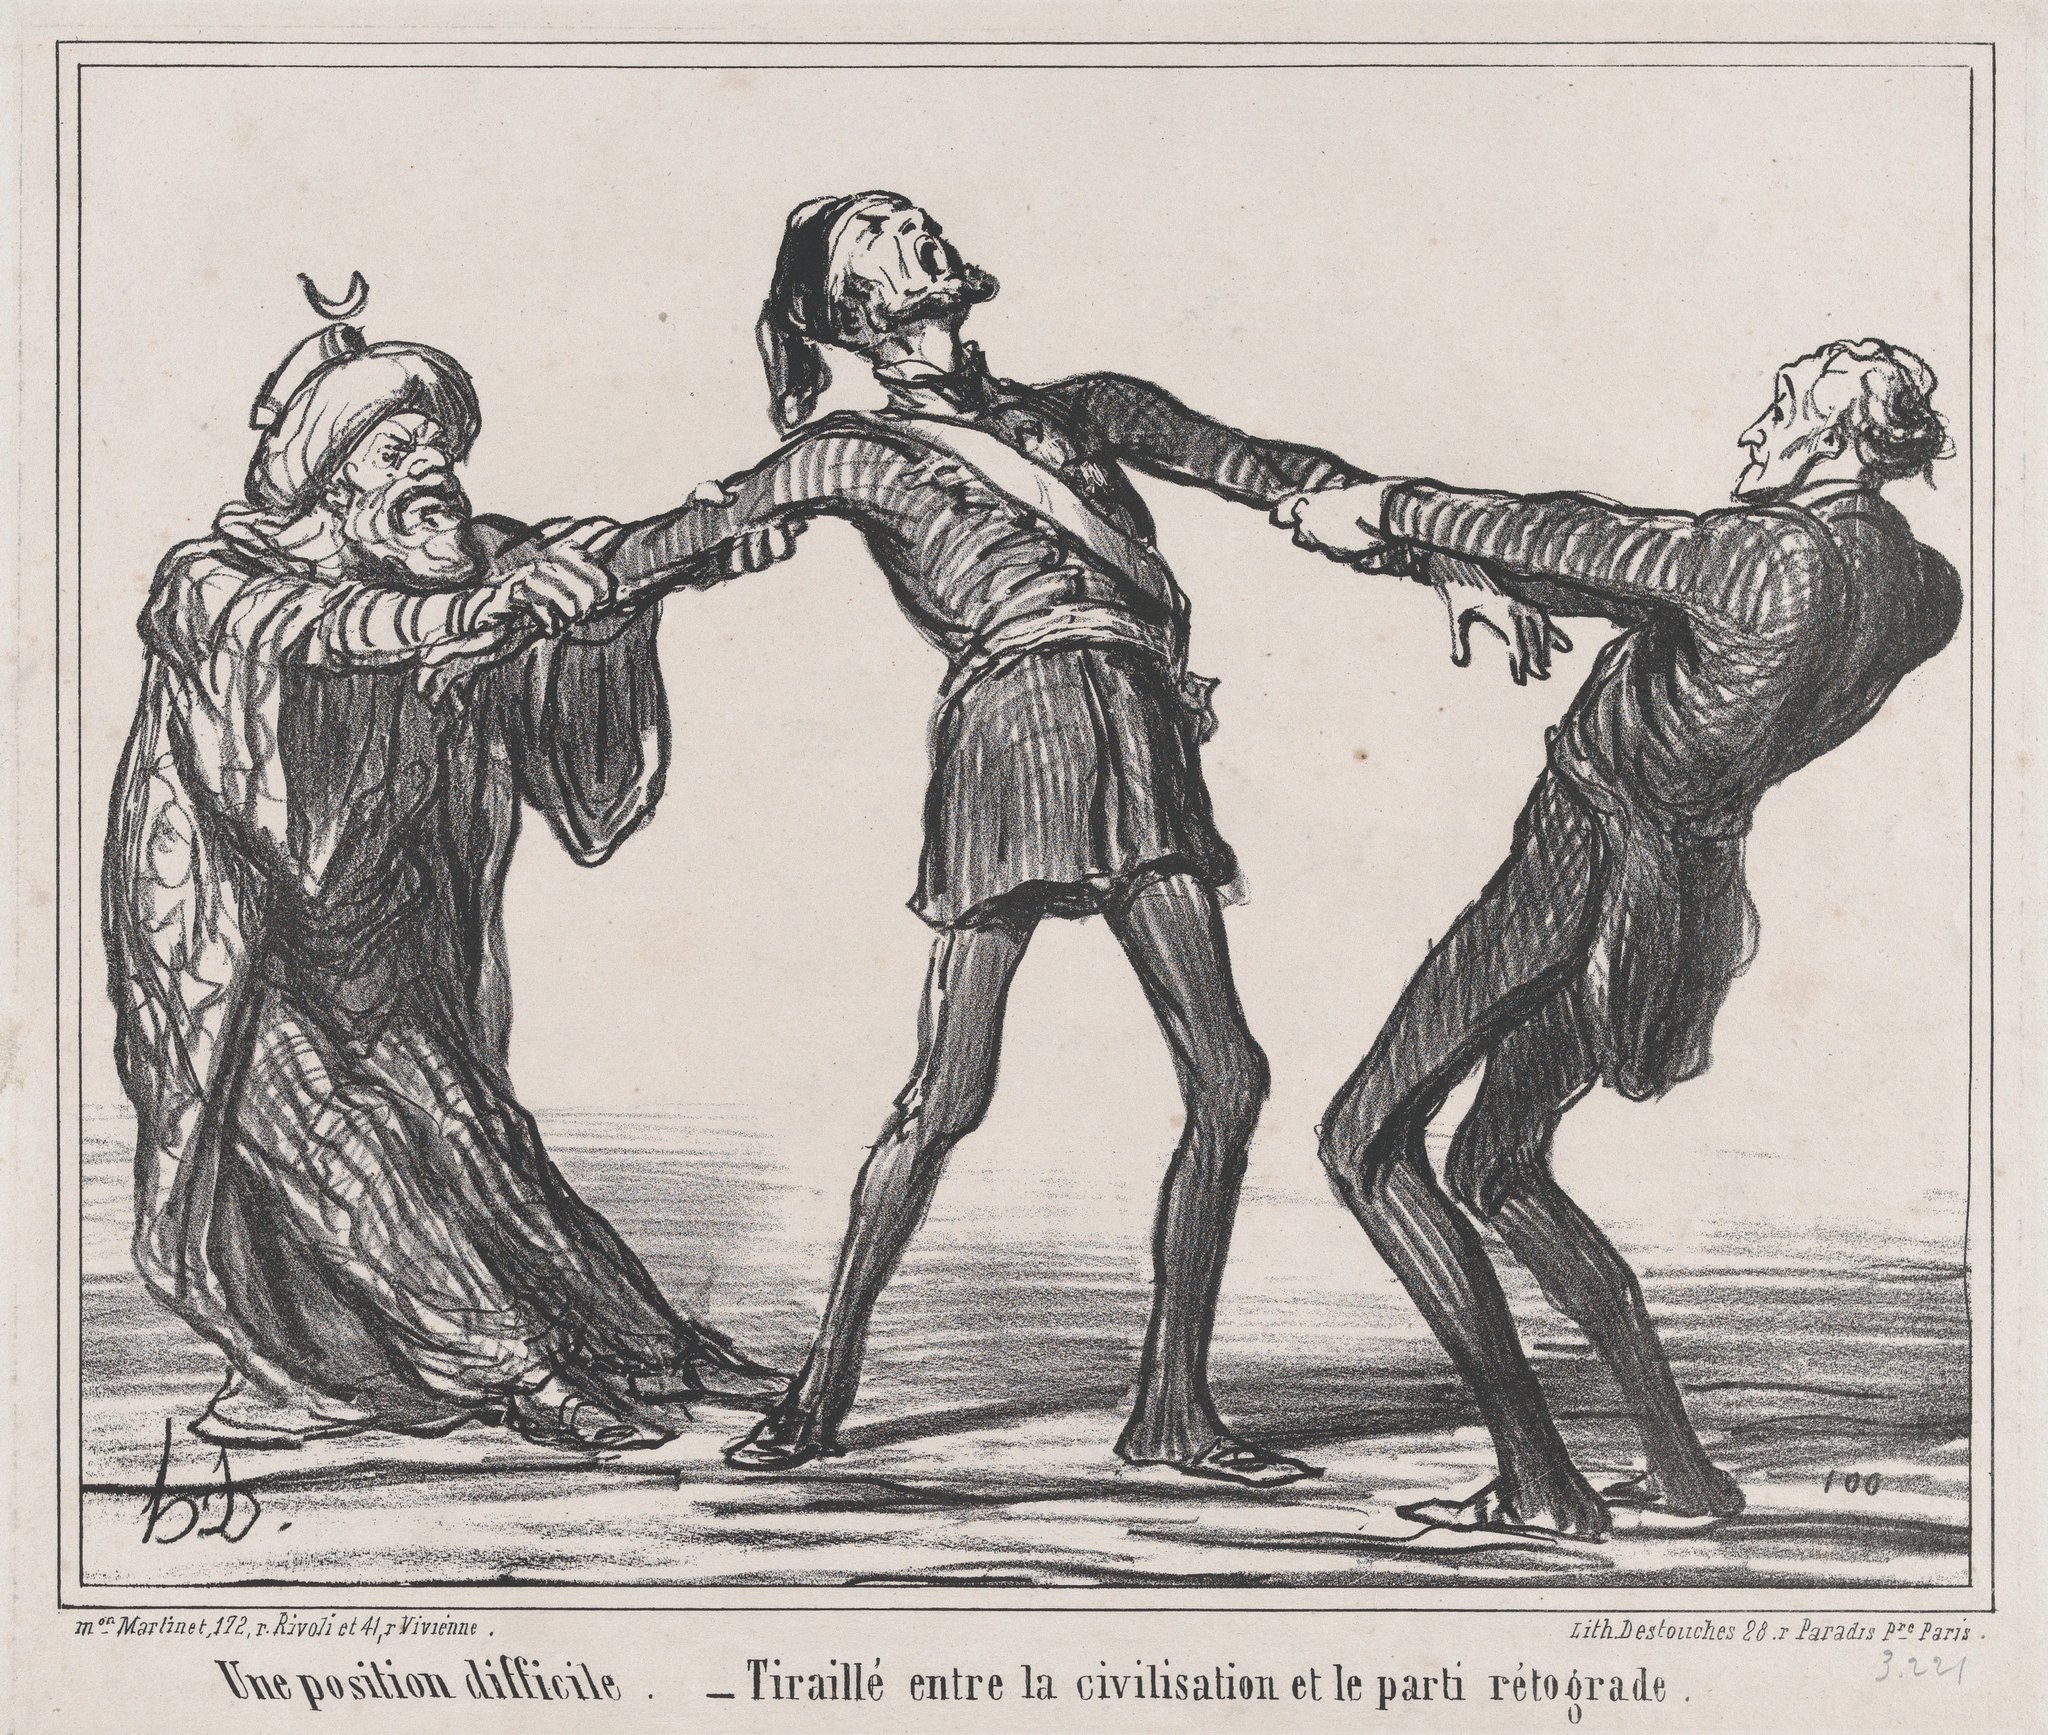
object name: print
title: Une position difficile, from Actualités, published in "Le Charivari"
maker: honoré daumier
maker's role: artist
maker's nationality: french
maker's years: 1808-1879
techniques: lithograph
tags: men